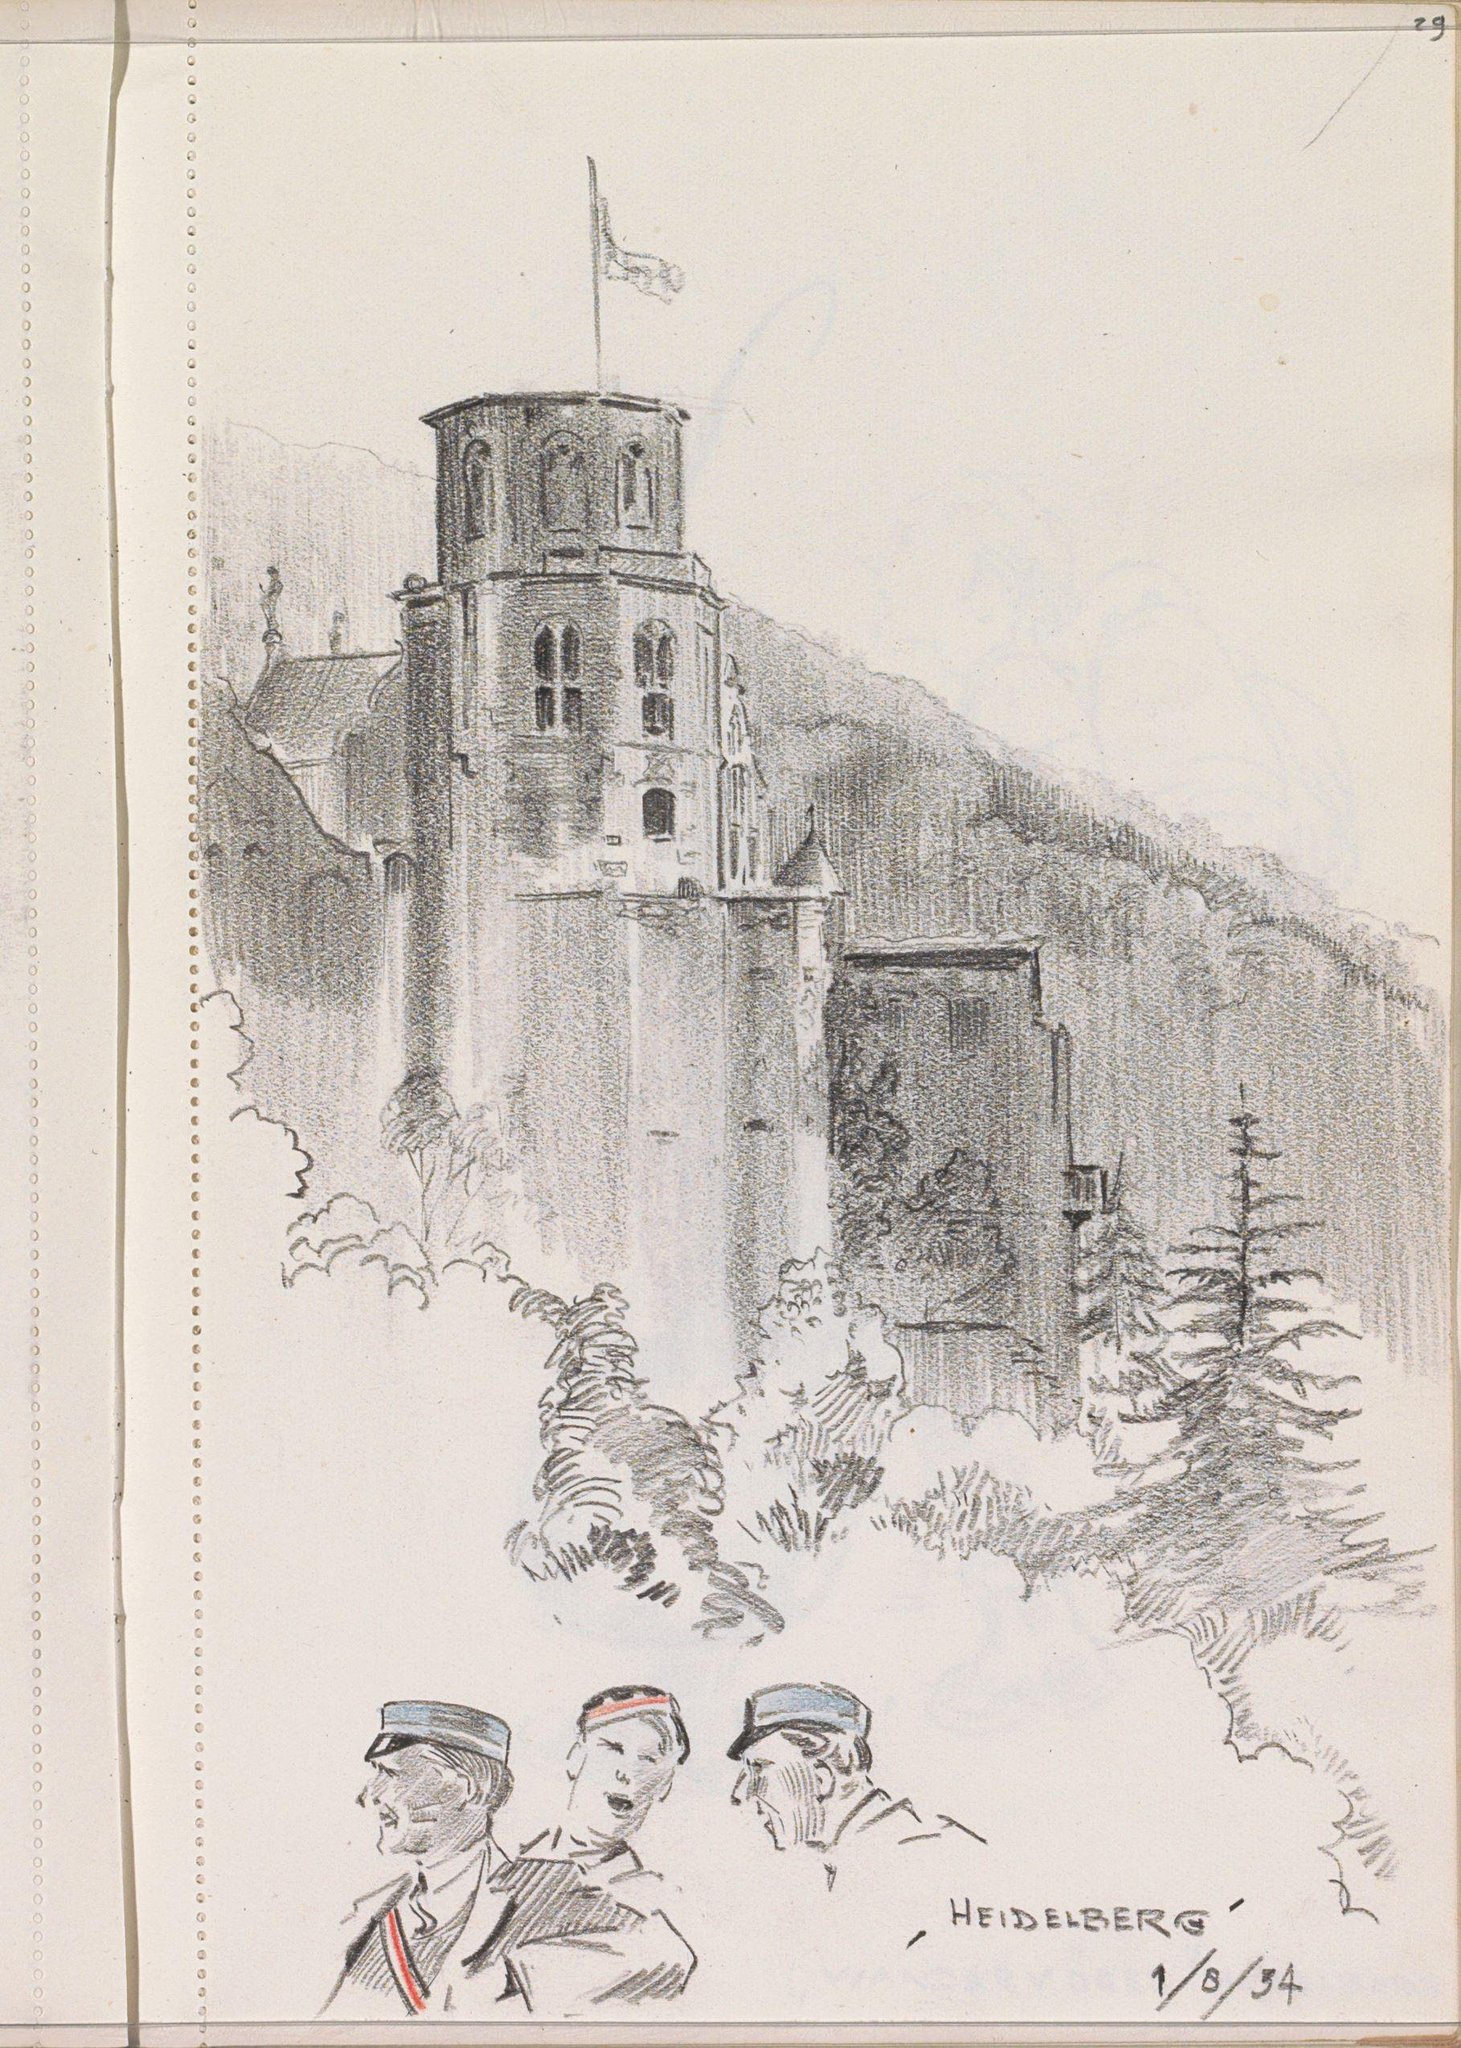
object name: sketchbook leaf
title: Toren van Slot Heidelberg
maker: otto verhagen (i)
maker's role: draughtsman, print maker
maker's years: 1885-1951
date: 1908-1934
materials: chalk, paper, pencil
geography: heidelberg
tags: adult man, landscape with tower or castle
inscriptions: date and inscription: ‘'Heidelberg'/ 1/8/34’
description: Tevens studies van mannen met petten. Pagina 29 uit een schetsboek met 60 bladen.